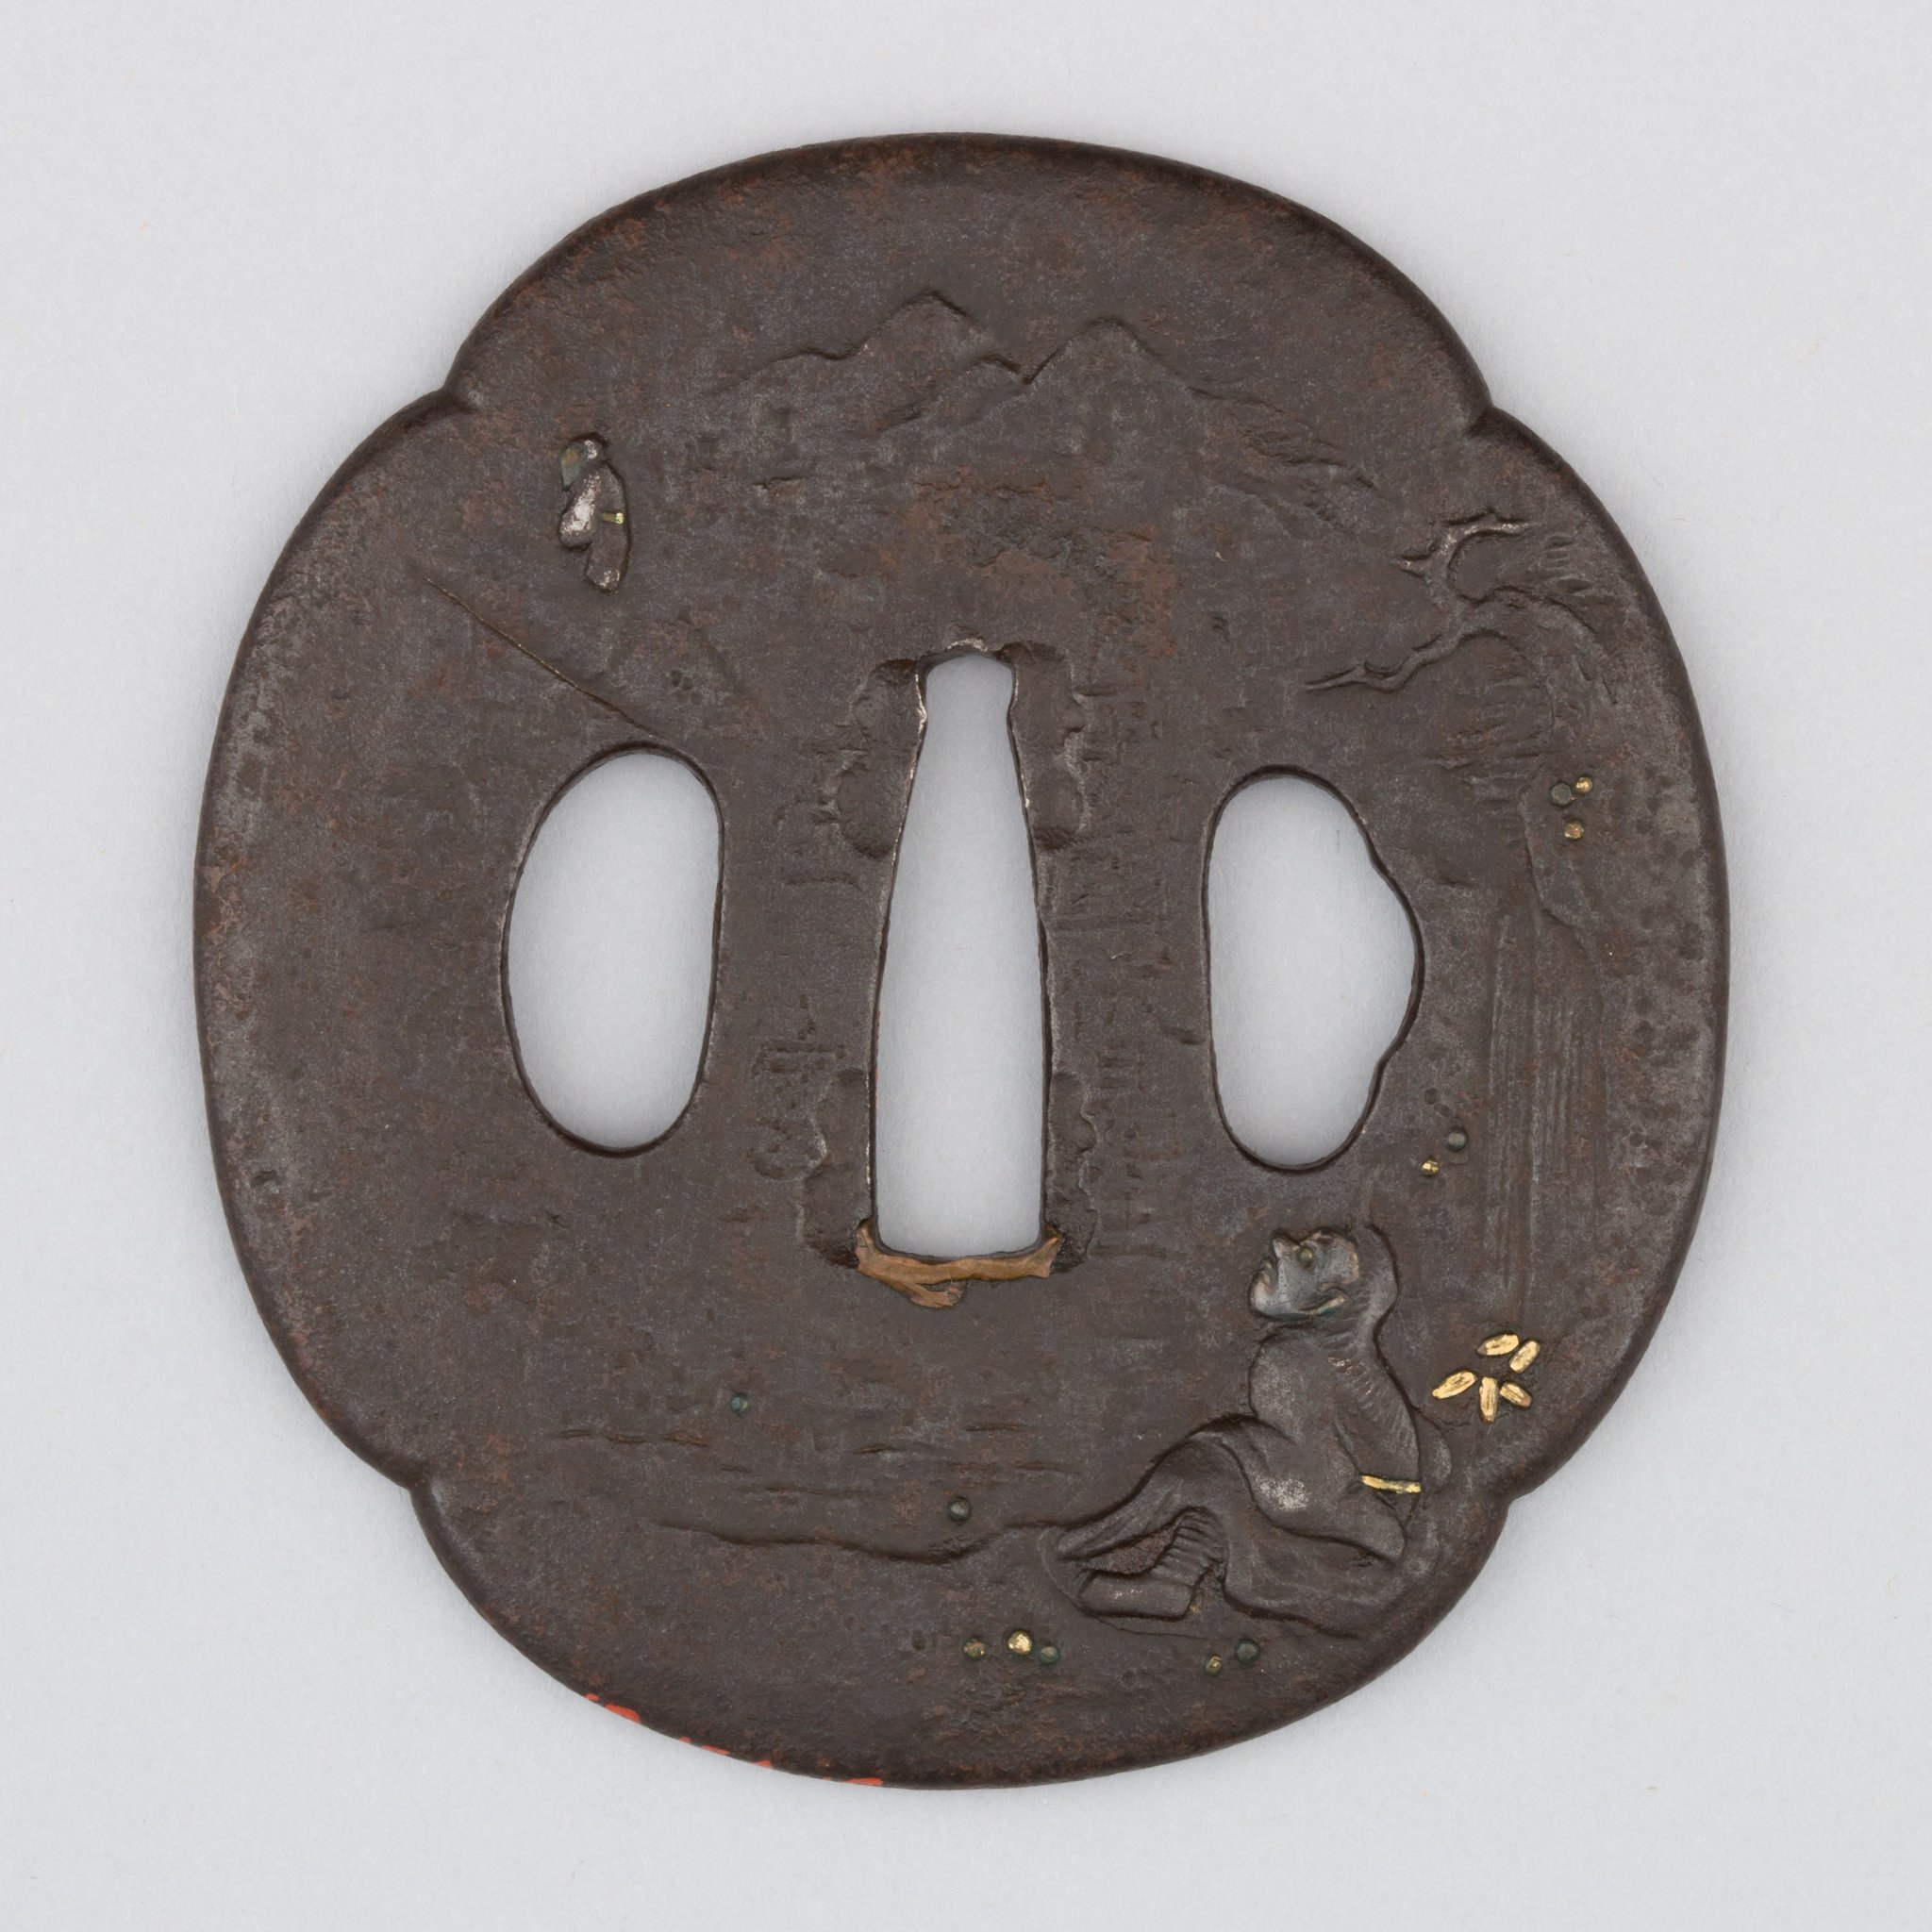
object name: sword guard tsuba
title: Sword Guard (Tsuba)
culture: japanese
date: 1701-1800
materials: copper, iron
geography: japan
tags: men